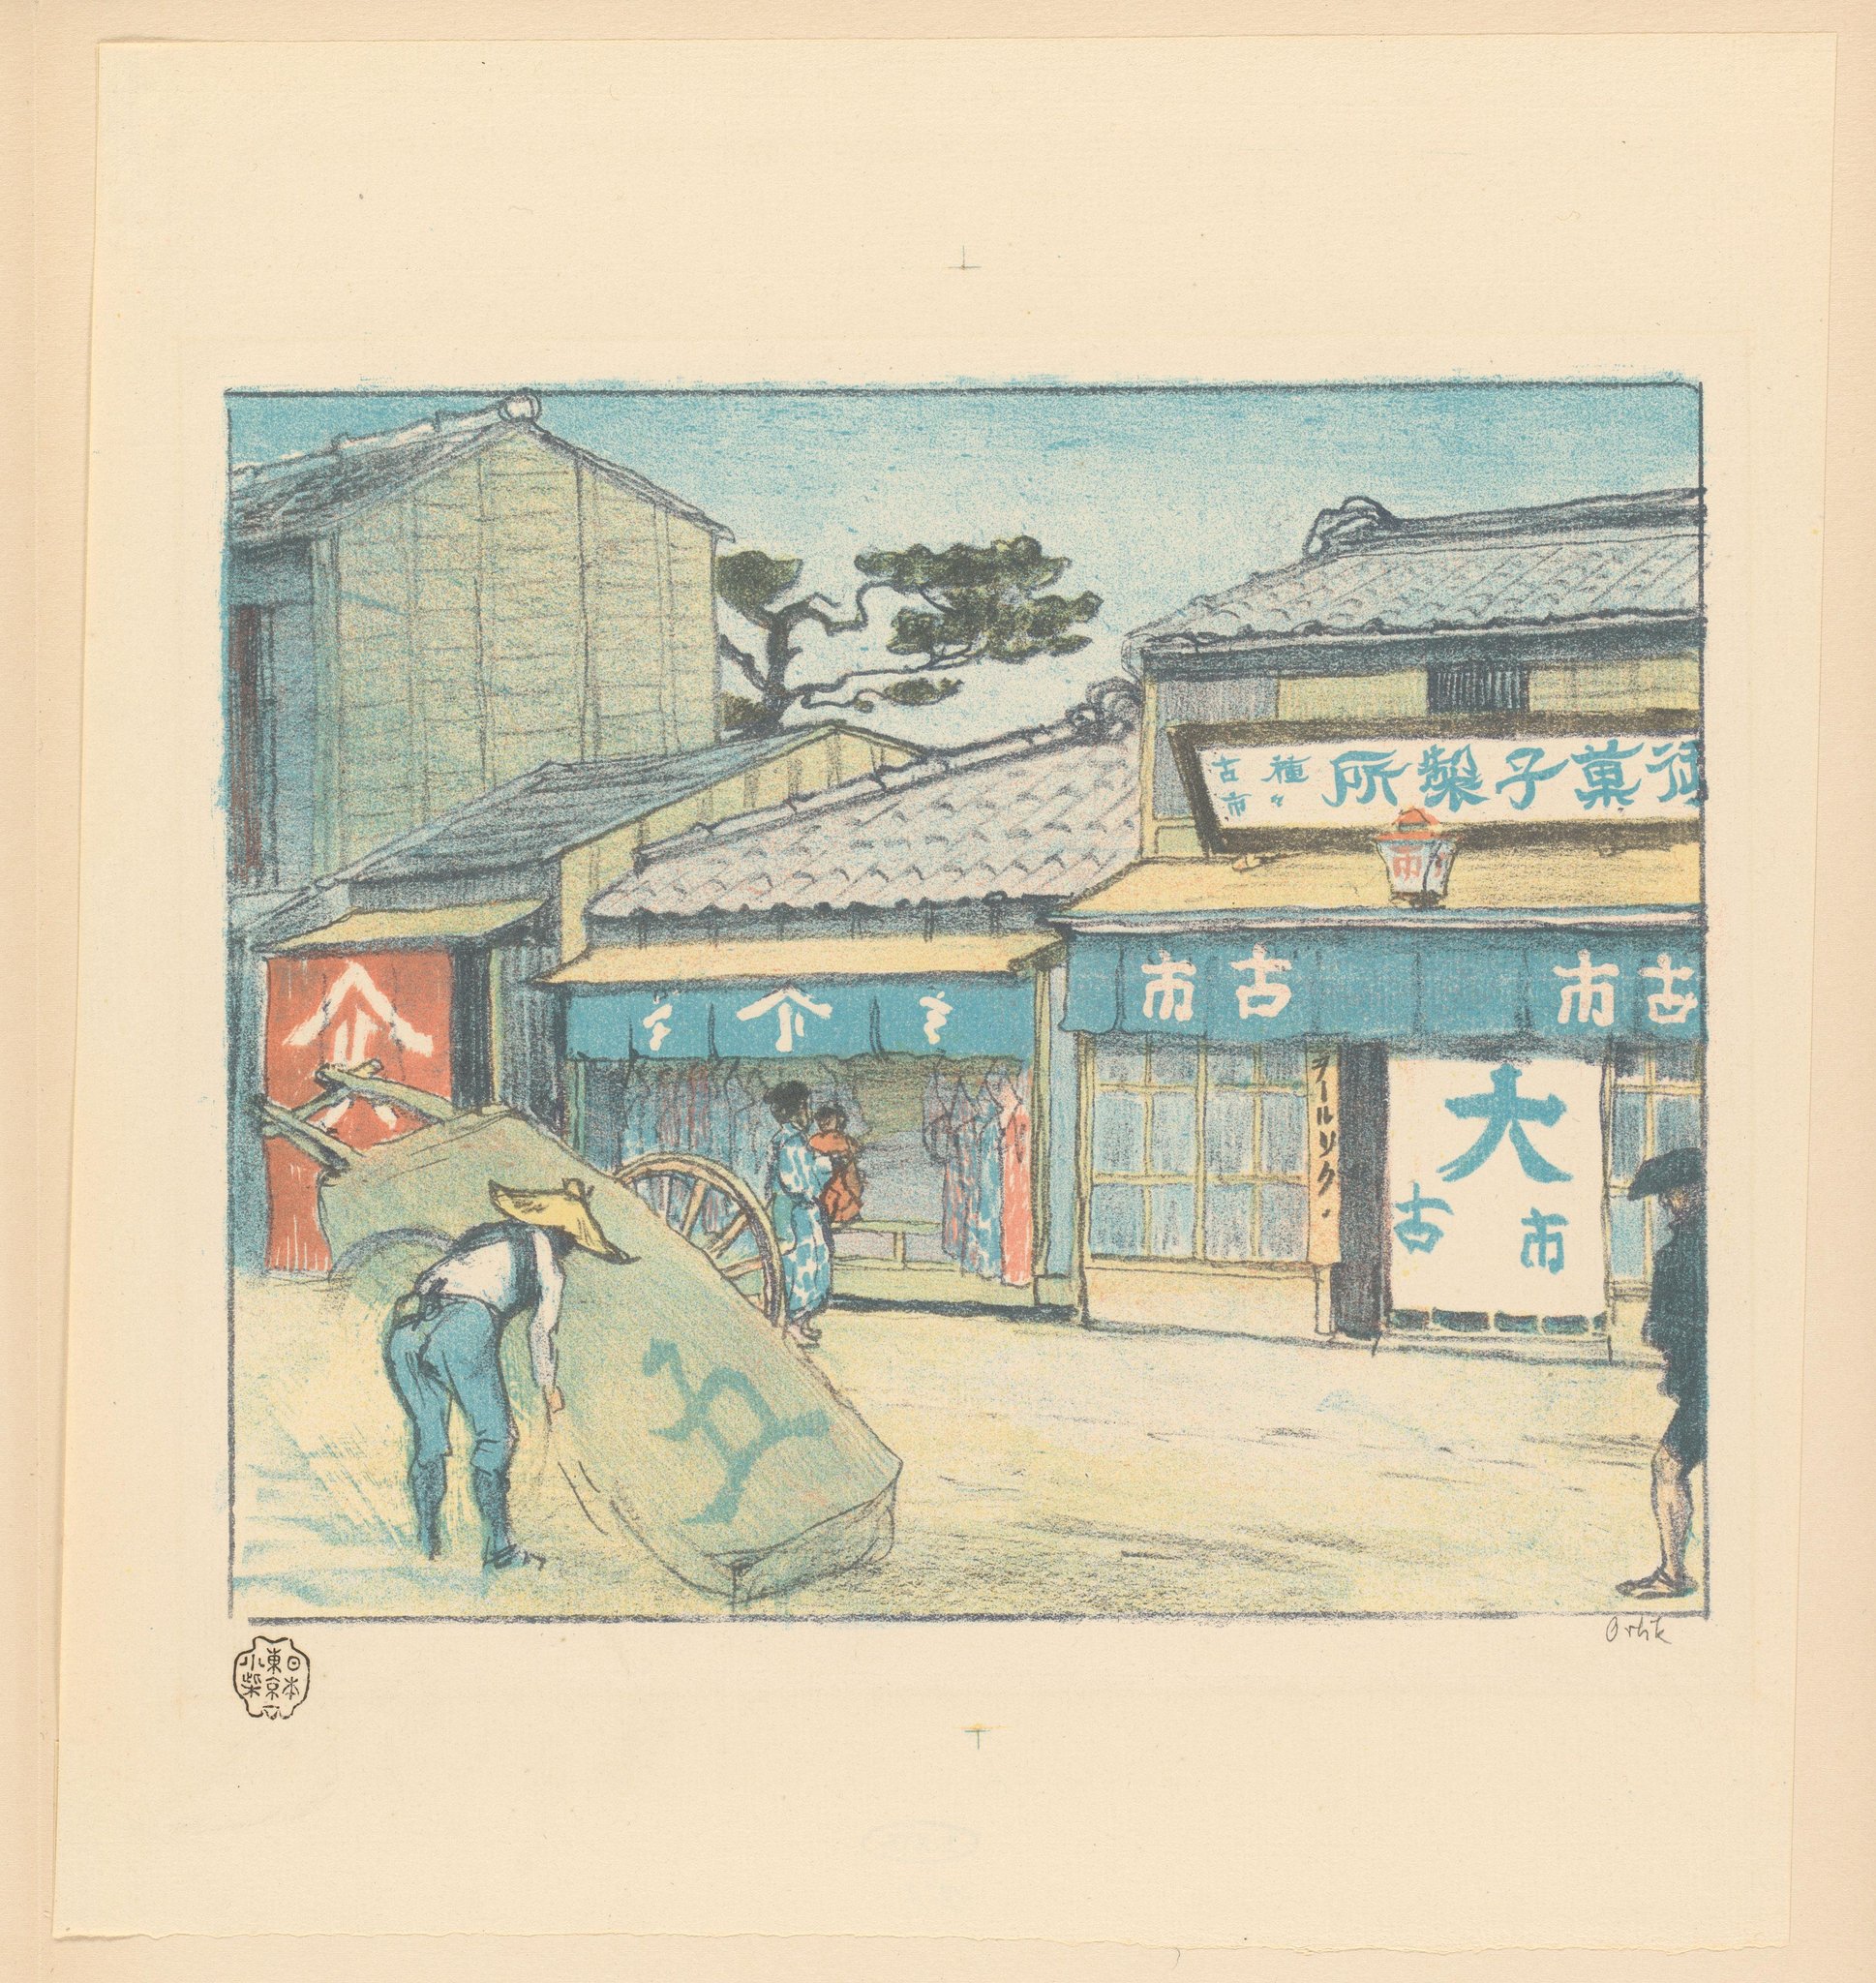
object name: print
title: Straat in Tokio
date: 1901-1903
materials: paper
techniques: lithograph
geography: tokyo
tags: hand-cart, street, shop-window, show-window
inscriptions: collector's mark: Lugt 2228, workshop stamp: ‘Nihon Tokyo Koshiba’